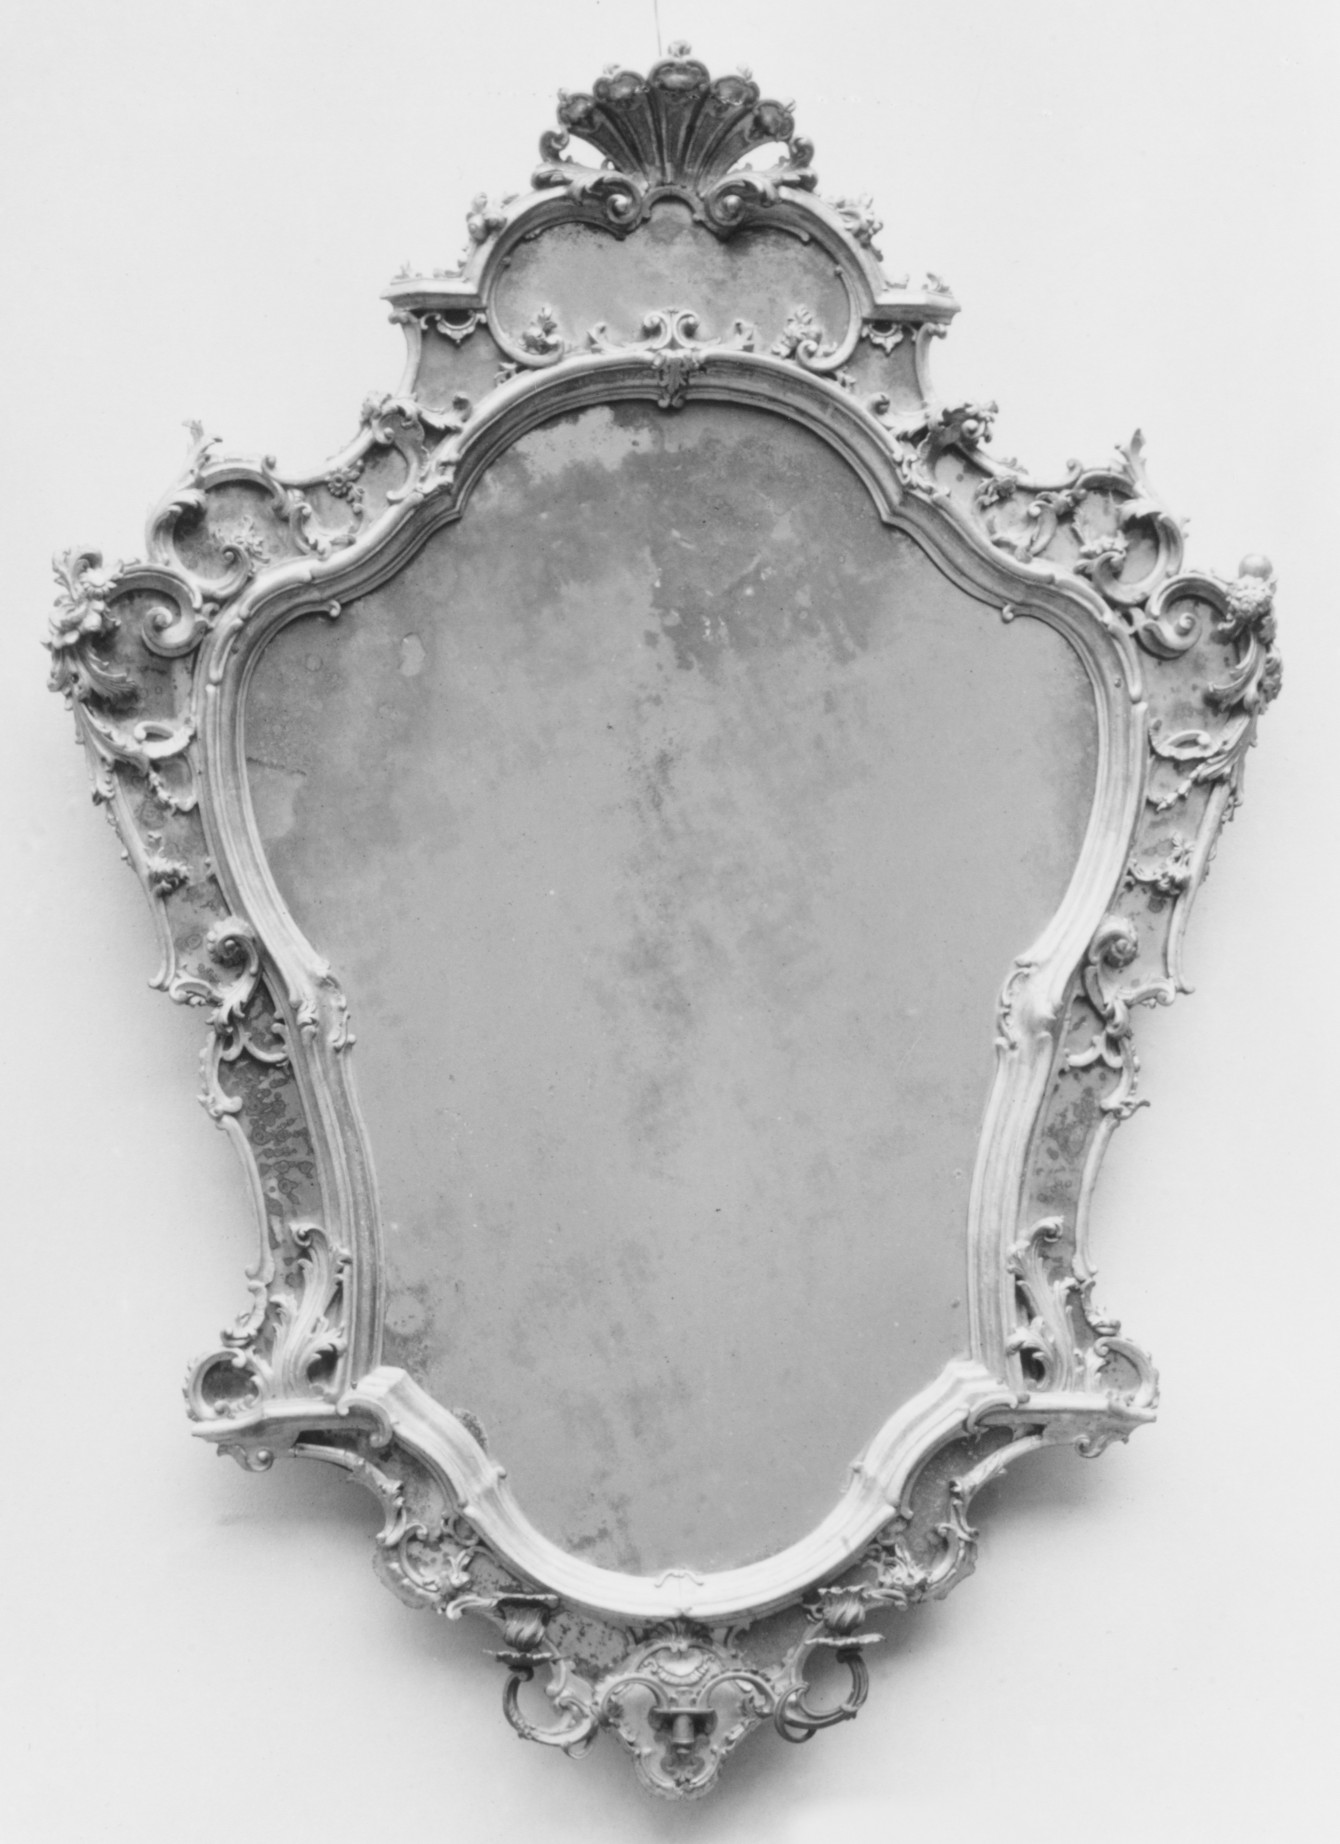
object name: mirror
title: Mirror (one of a pair)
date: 1701-1800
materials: gilt bronze, wood